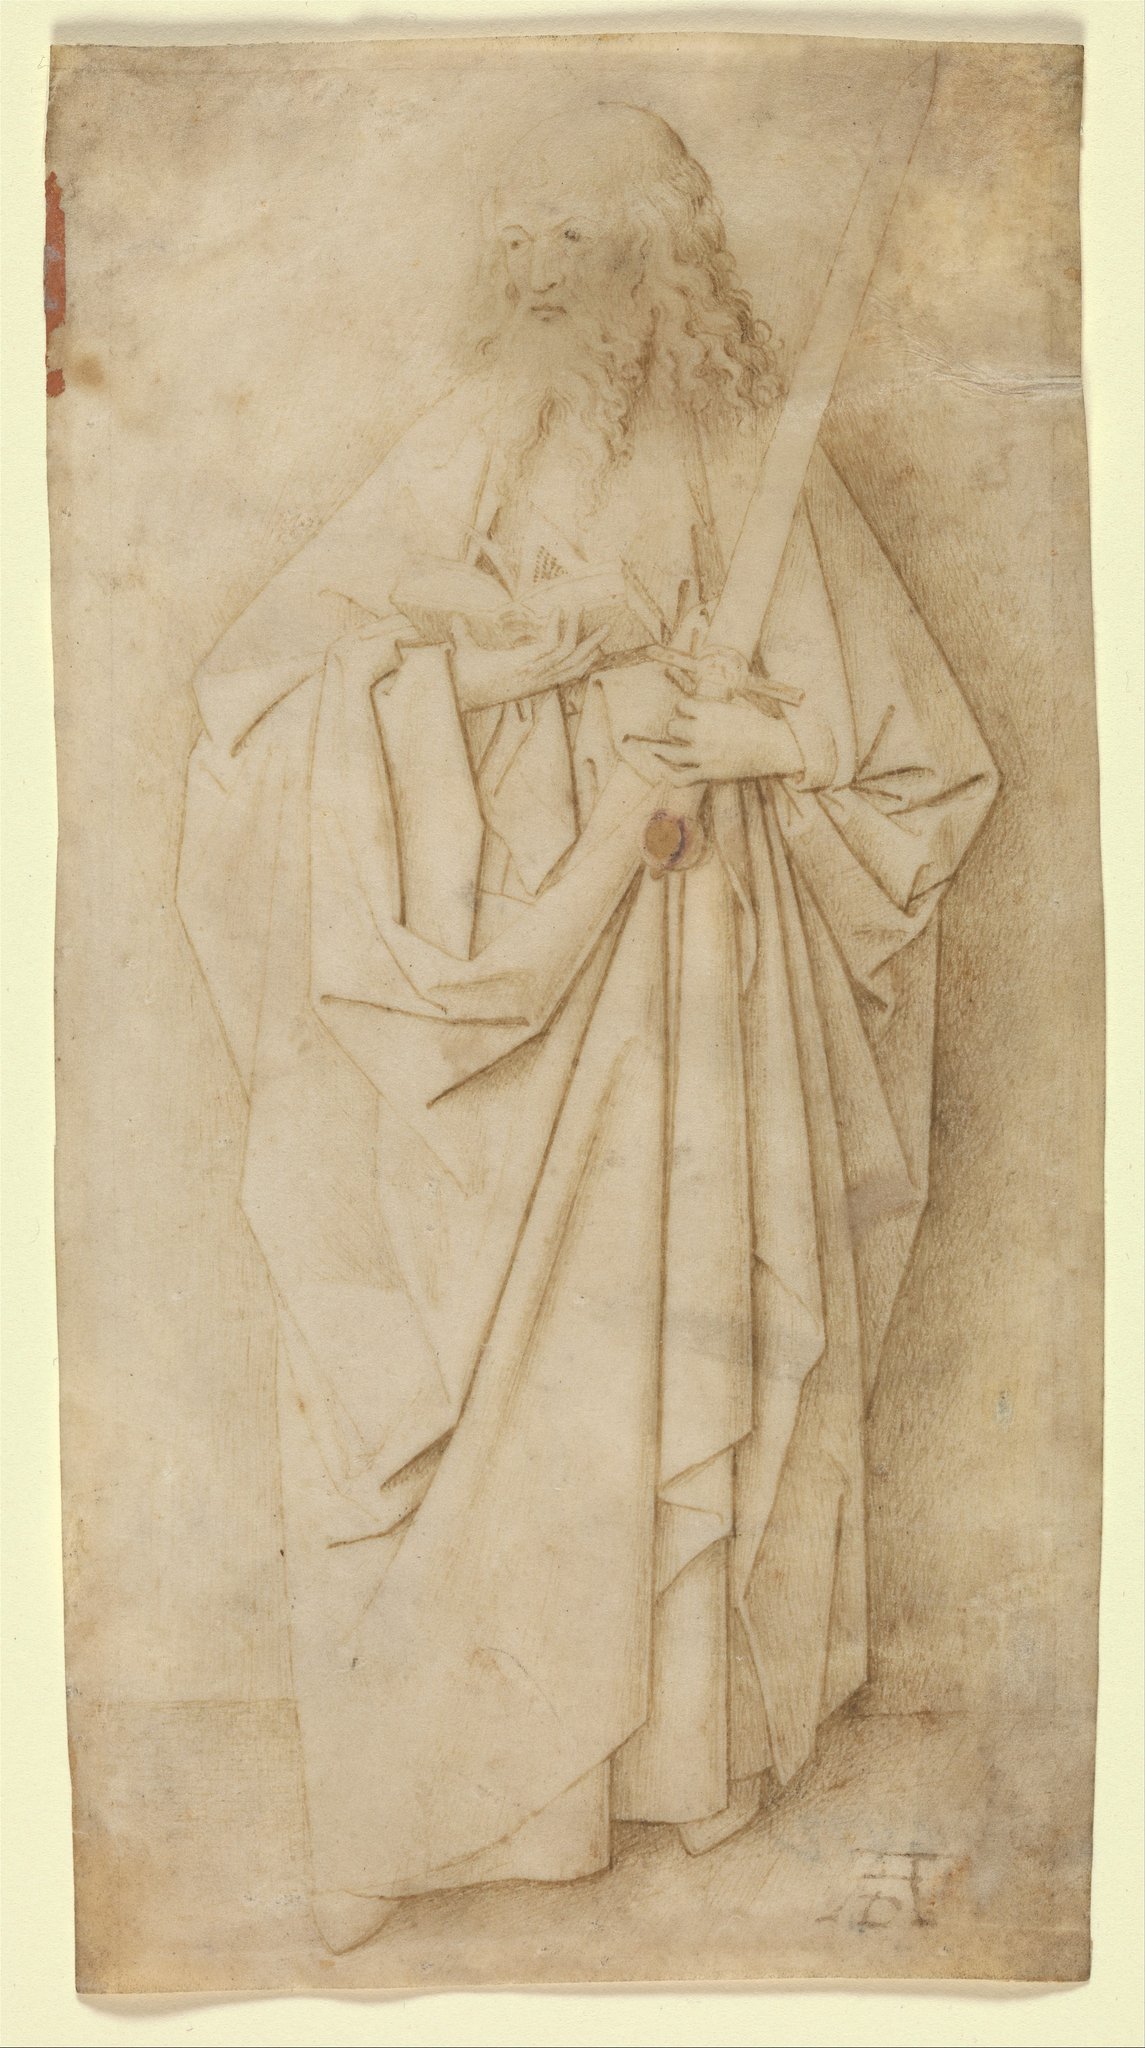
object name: drawing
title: Saint Paul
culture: dutch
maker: circle of jan van eyck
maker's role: artist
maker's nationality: netherlandish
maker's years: 1390-1441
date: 1430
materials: gold, ink, parchment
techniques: brush, heightening, pen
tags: saint paul